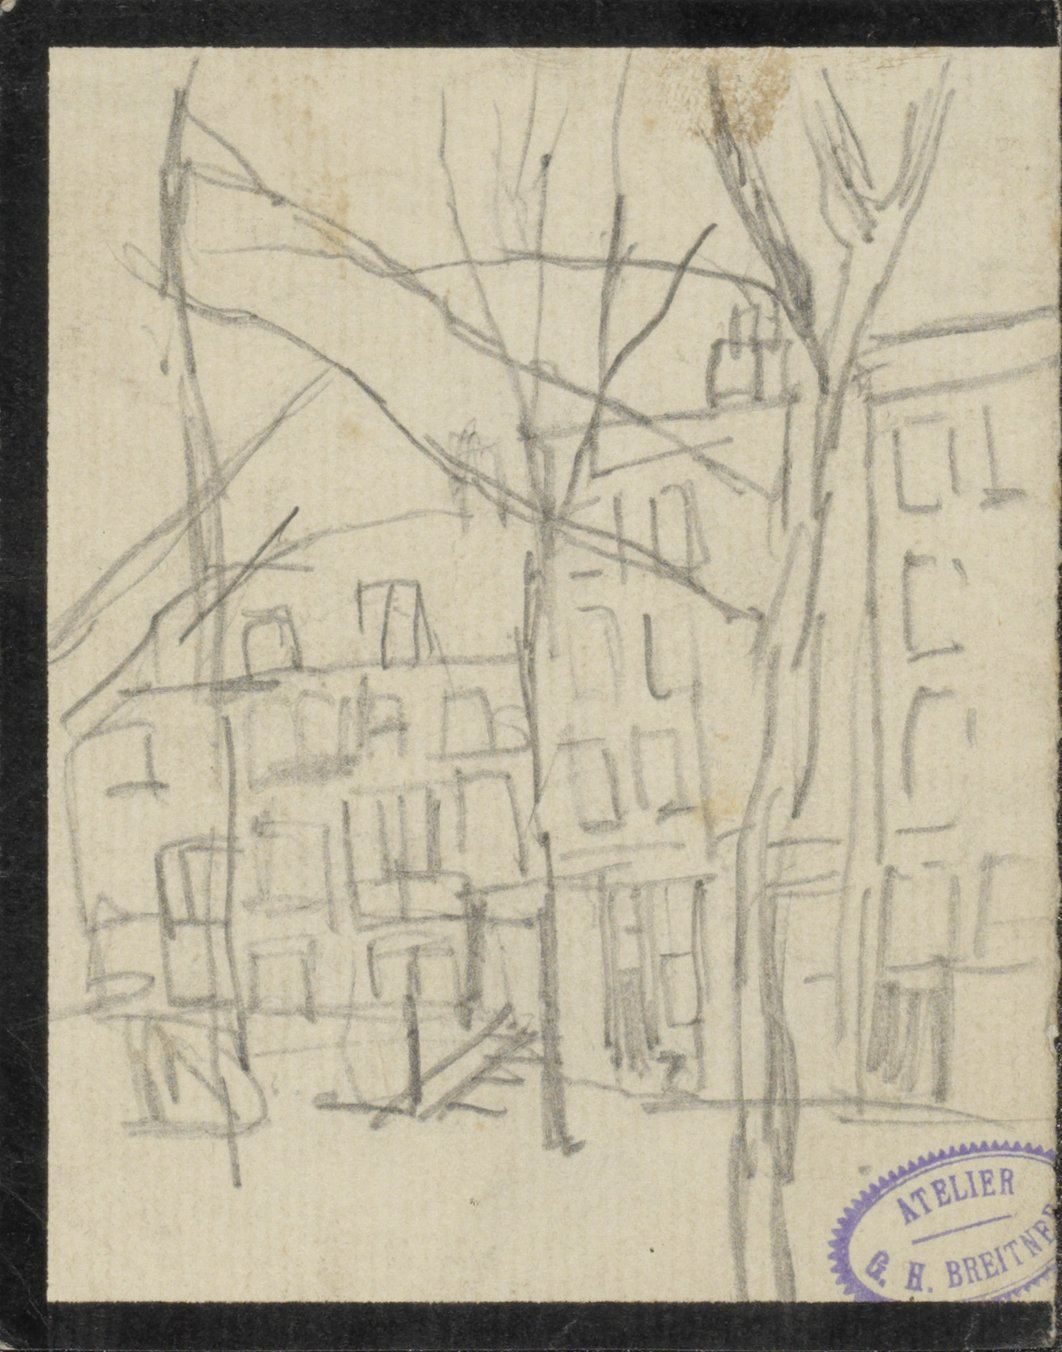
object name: drawing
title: Gezicht op de hoek van het Thorbeckeplein en de Herengracht te Amsterdam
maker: george hendrik breitner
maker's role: draughtsman, painter, print maker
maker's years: 1857-1923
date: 1897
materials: paper, pencil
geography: amsterdam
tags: square, place, circus, etc., street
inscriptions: collector's mark: Lugt 2228, workshop stamp: Lugt 291d, annotation: ‘h/ Thorbeckeplein &/ Heerengracht/ uit Verhagens[?] wachtkamer’